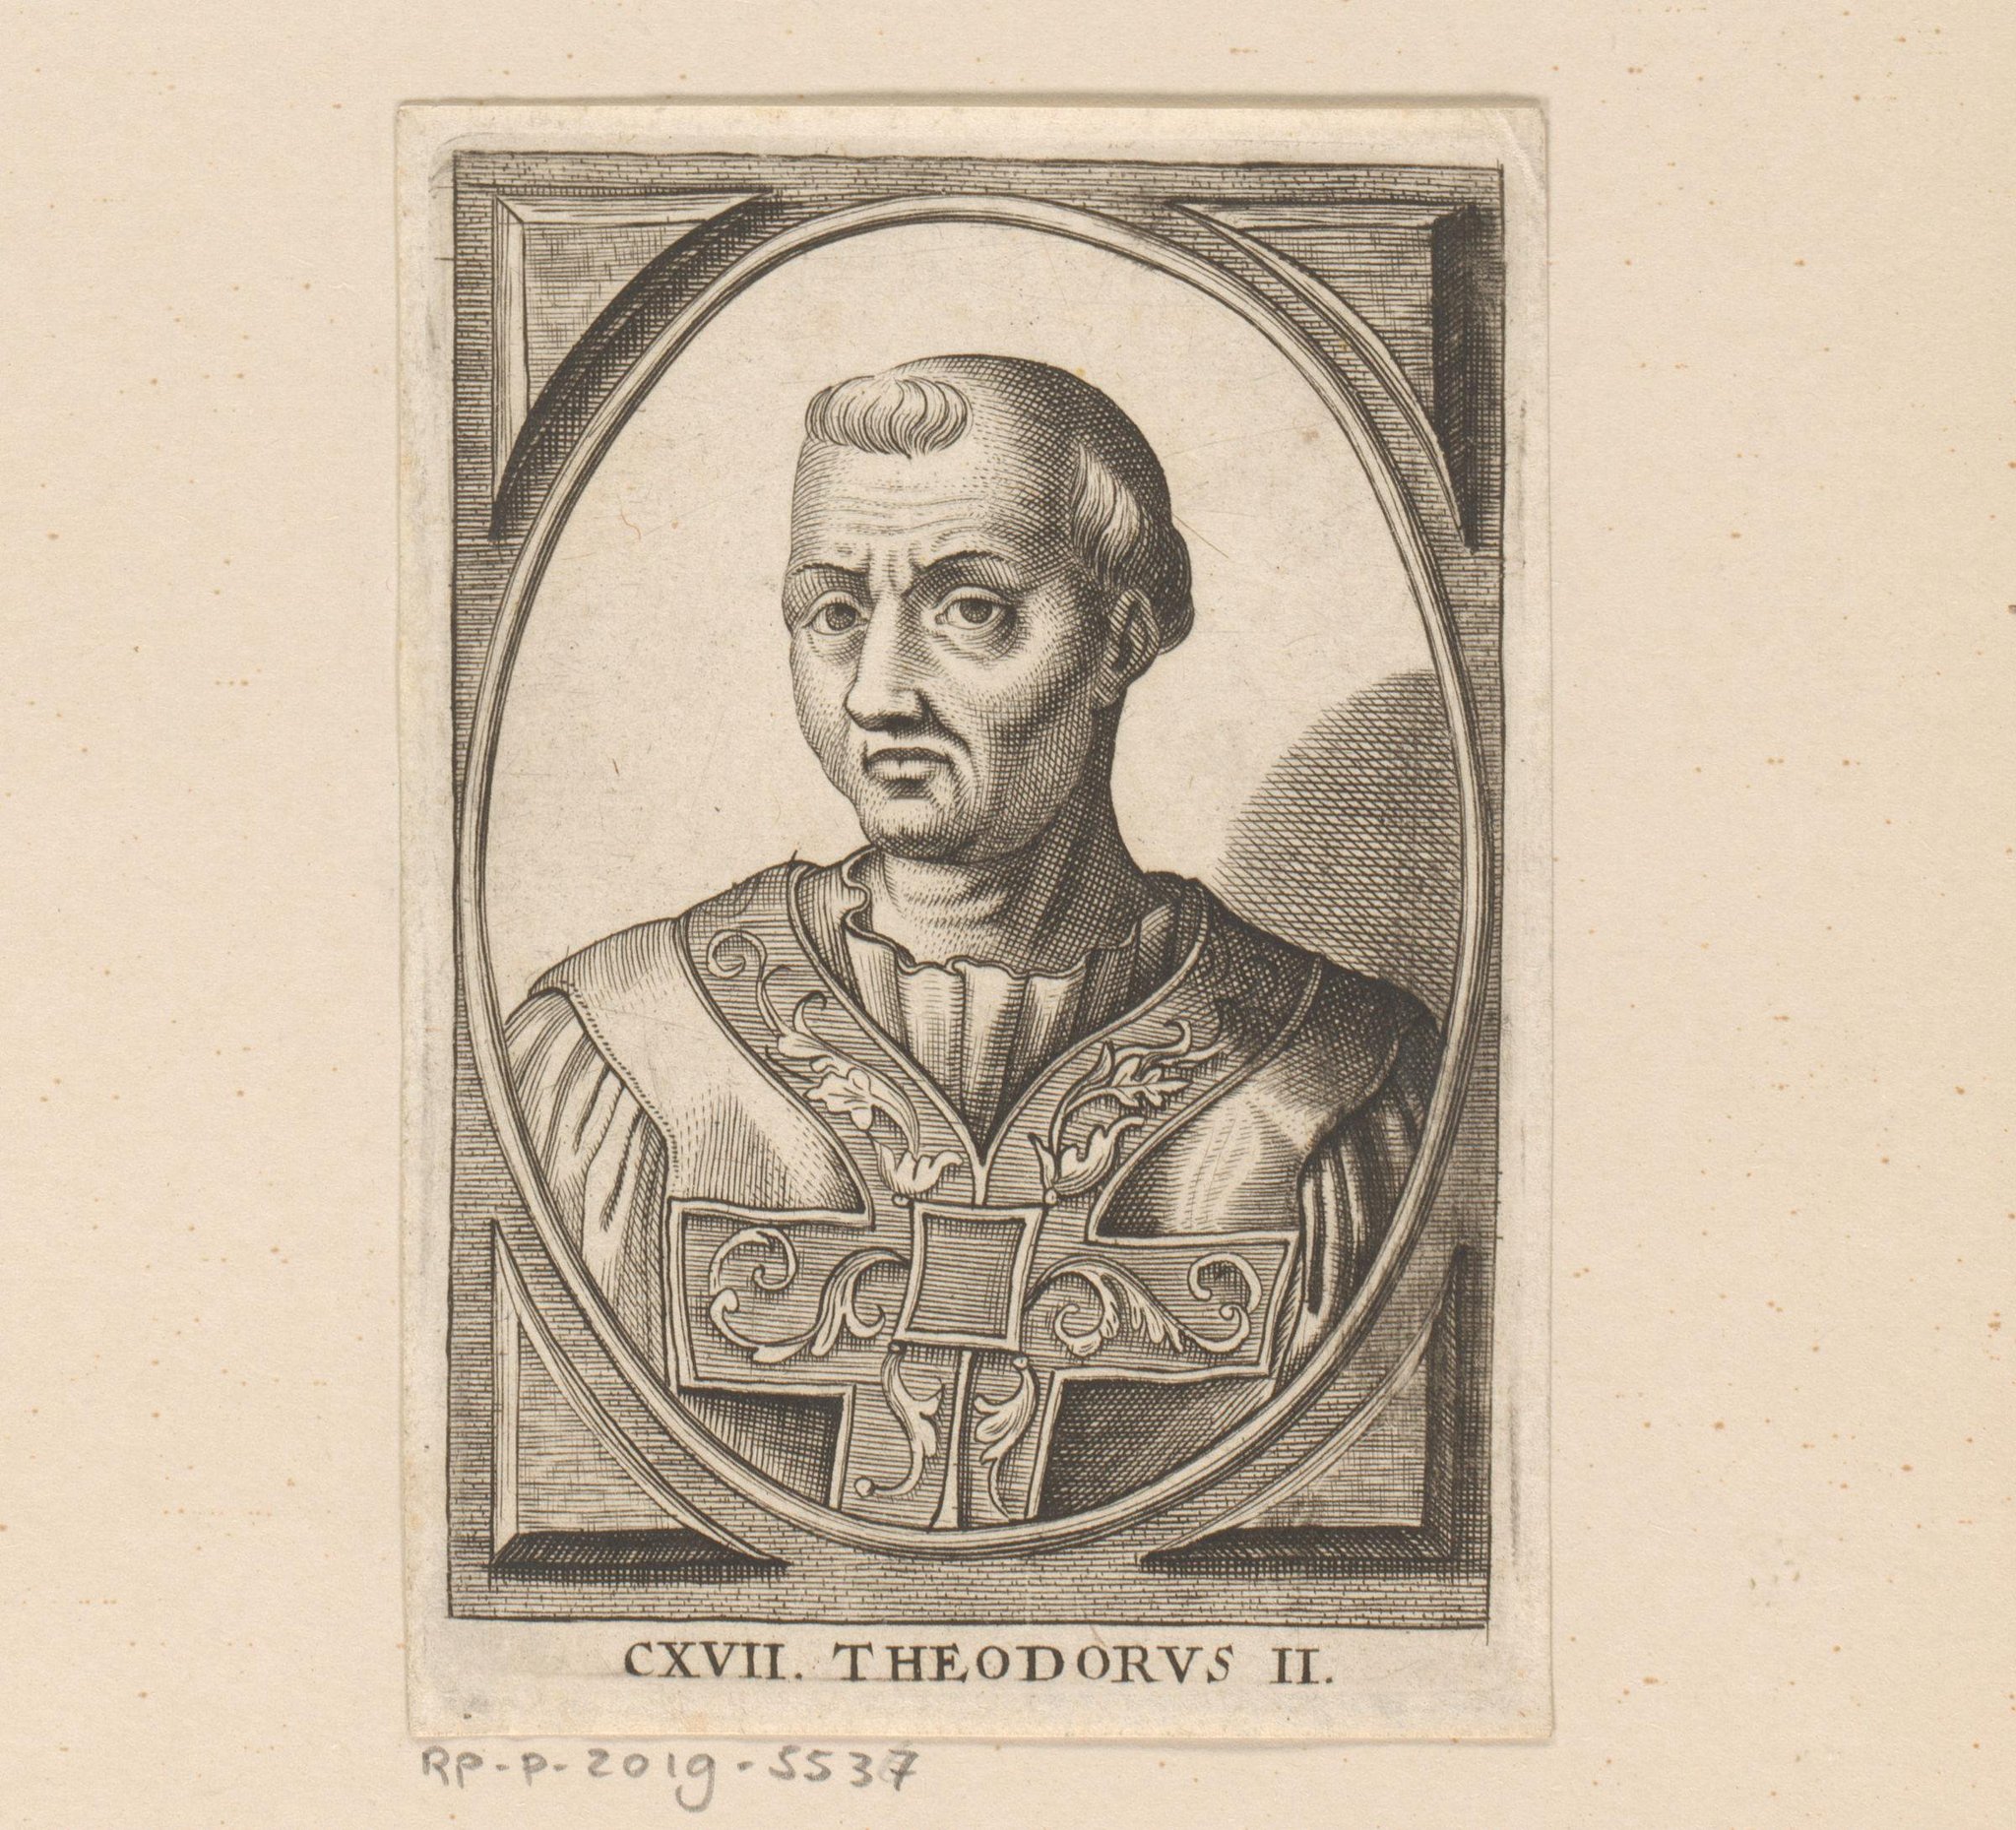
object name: print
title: Portret van paus Theodorus II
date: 1679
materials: paper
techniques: engraving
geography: antwerp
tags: historical persons, pope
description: Prent mogelijk voor het eerst gebruikt in: Hazart, Cornelius. Triomph der pausen van Roomen over alle hare benyders ende bestryders (...). Antwerpen: Michiel Cnobbaert, 1679, dl. 2. Prent ook gebruikt in andere publicaties van deze uitgever. Zie bijvoorbeeld: Propylaeum ad acta sanctorum maii sub felicissimus auspiciis Innocentii XI (...). Antwerpen: Michiel Cnobbaert, s.a.